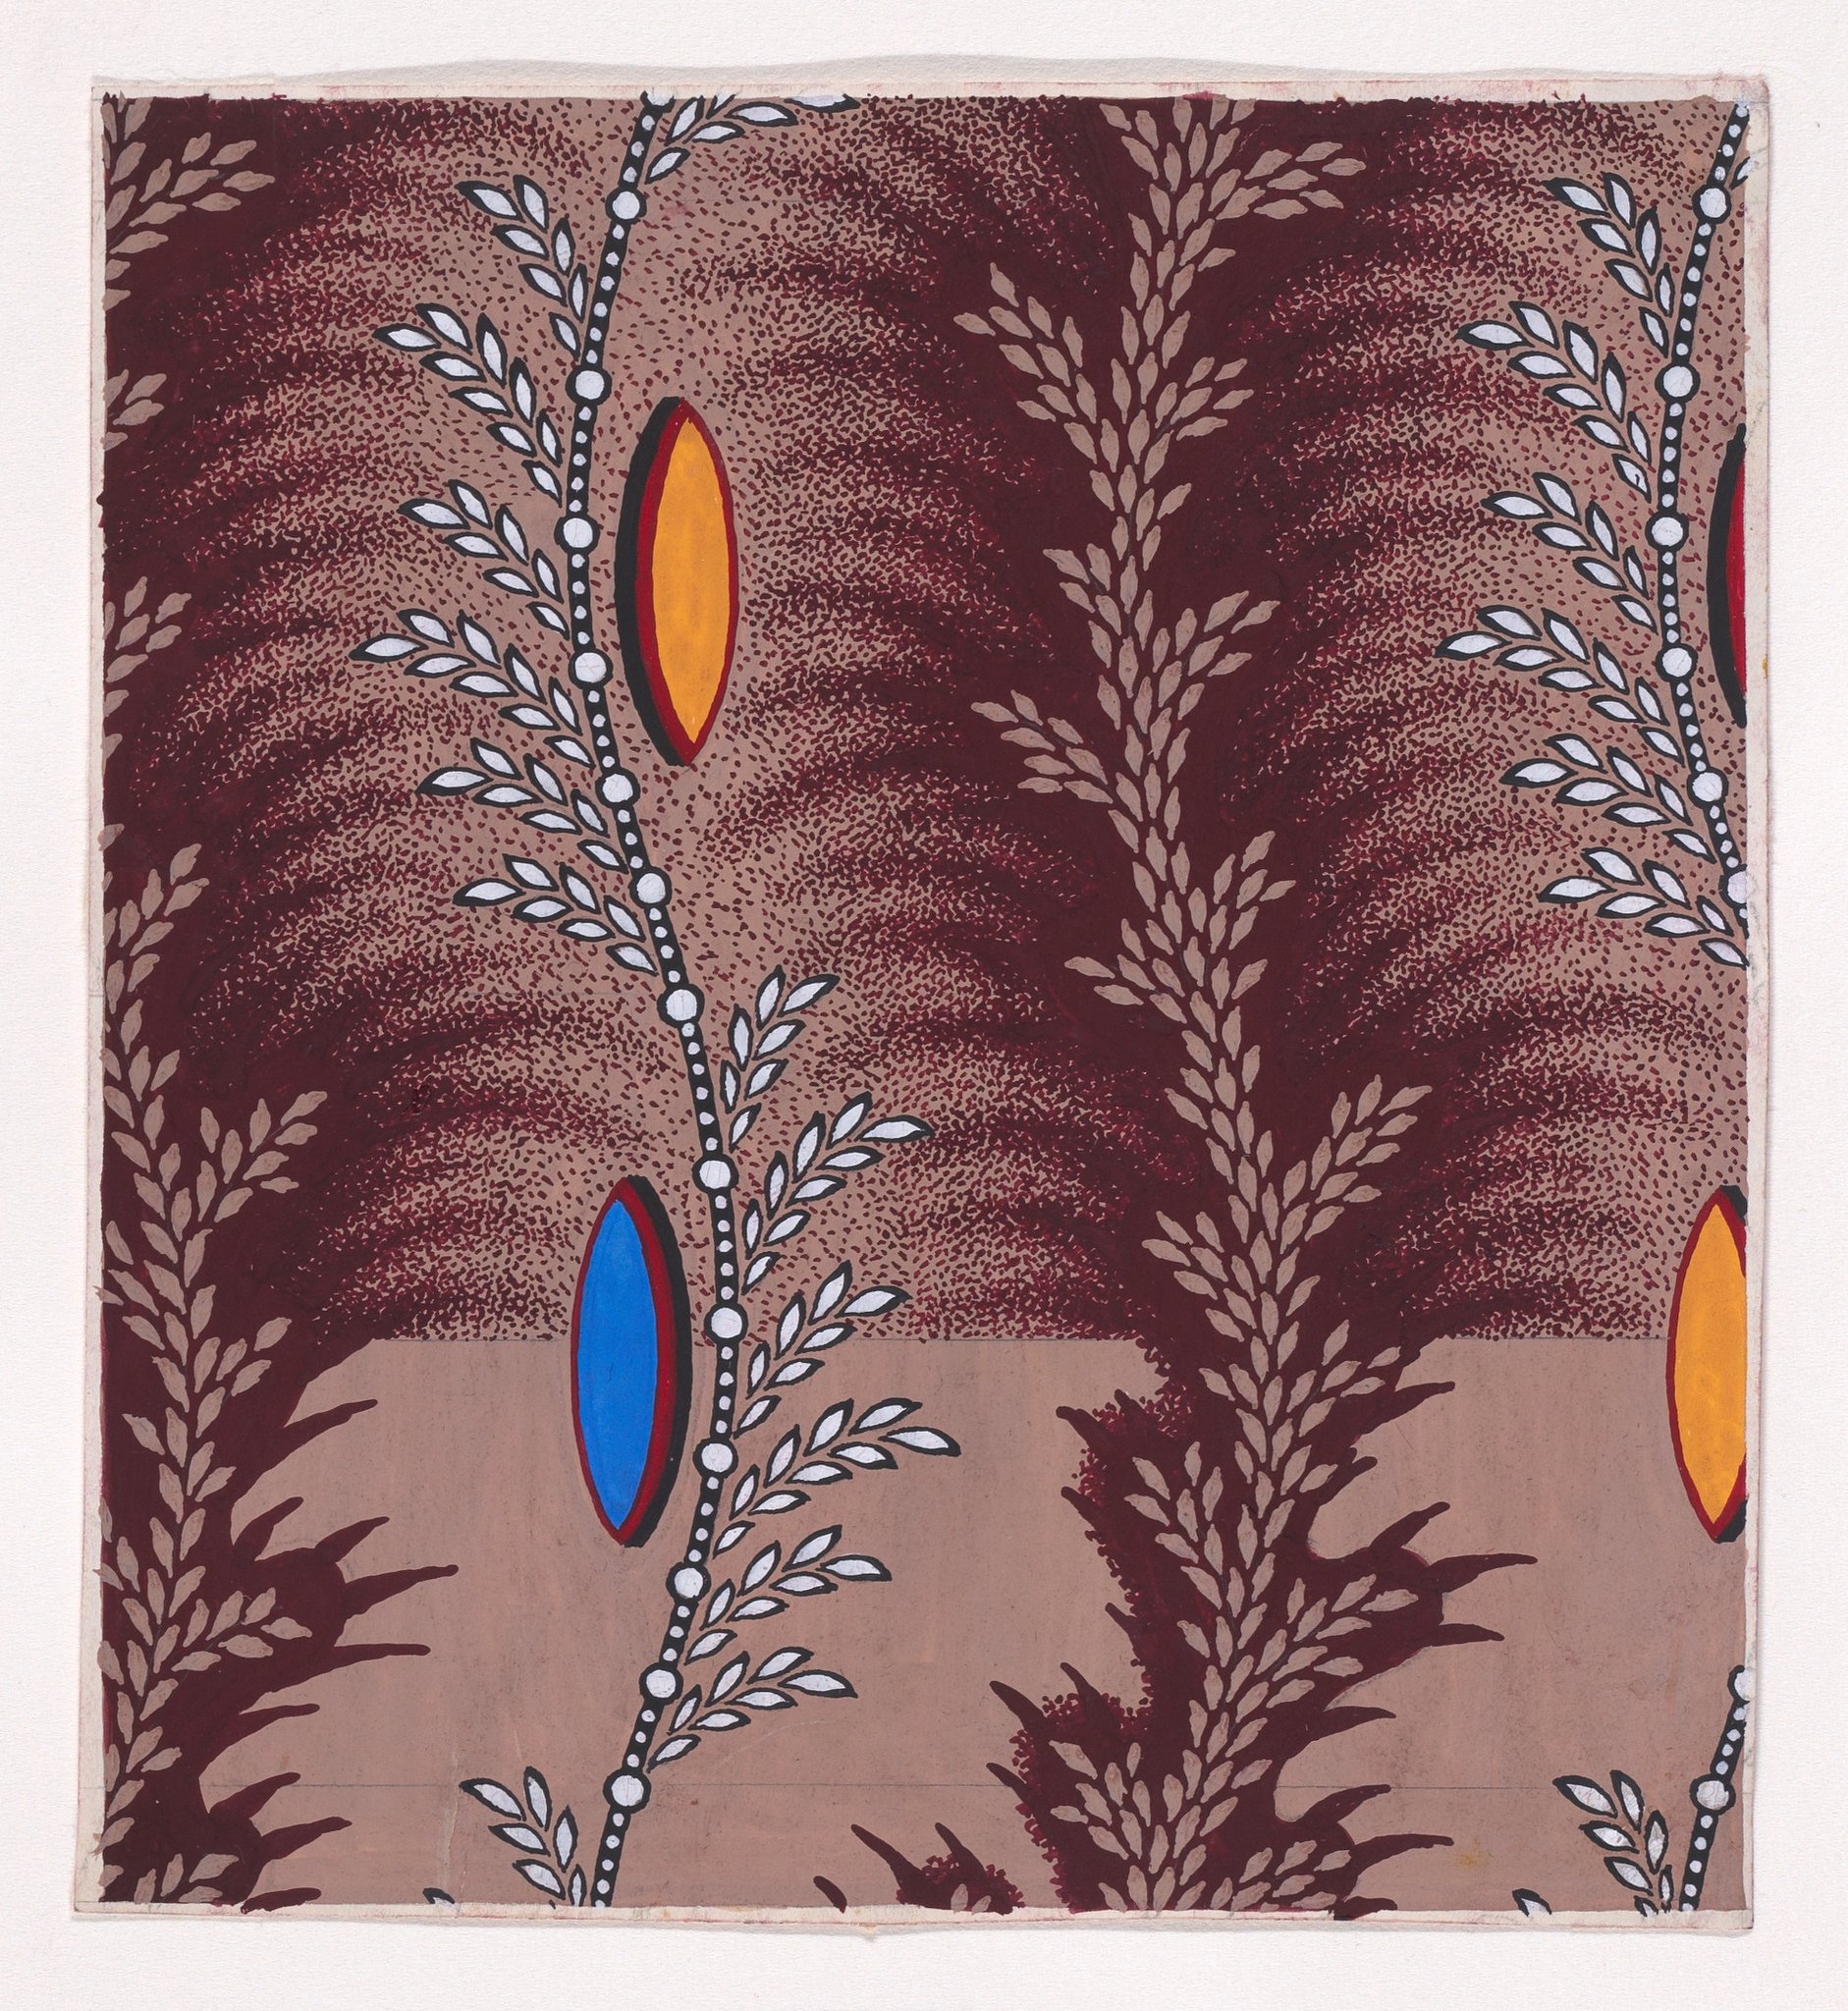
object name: drawing ornament architecture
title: Textile Design with Alternating Vertical Rows of Undulating Stylized Wheat Ears and Undulating Strips of Pearls with Alternating Offsetting Wheat Ears and Lens Shapes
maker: anonymous, alsatian, 19th century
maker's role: artist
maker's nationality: alsatian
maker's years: 1800-1900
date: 1840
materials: gouache